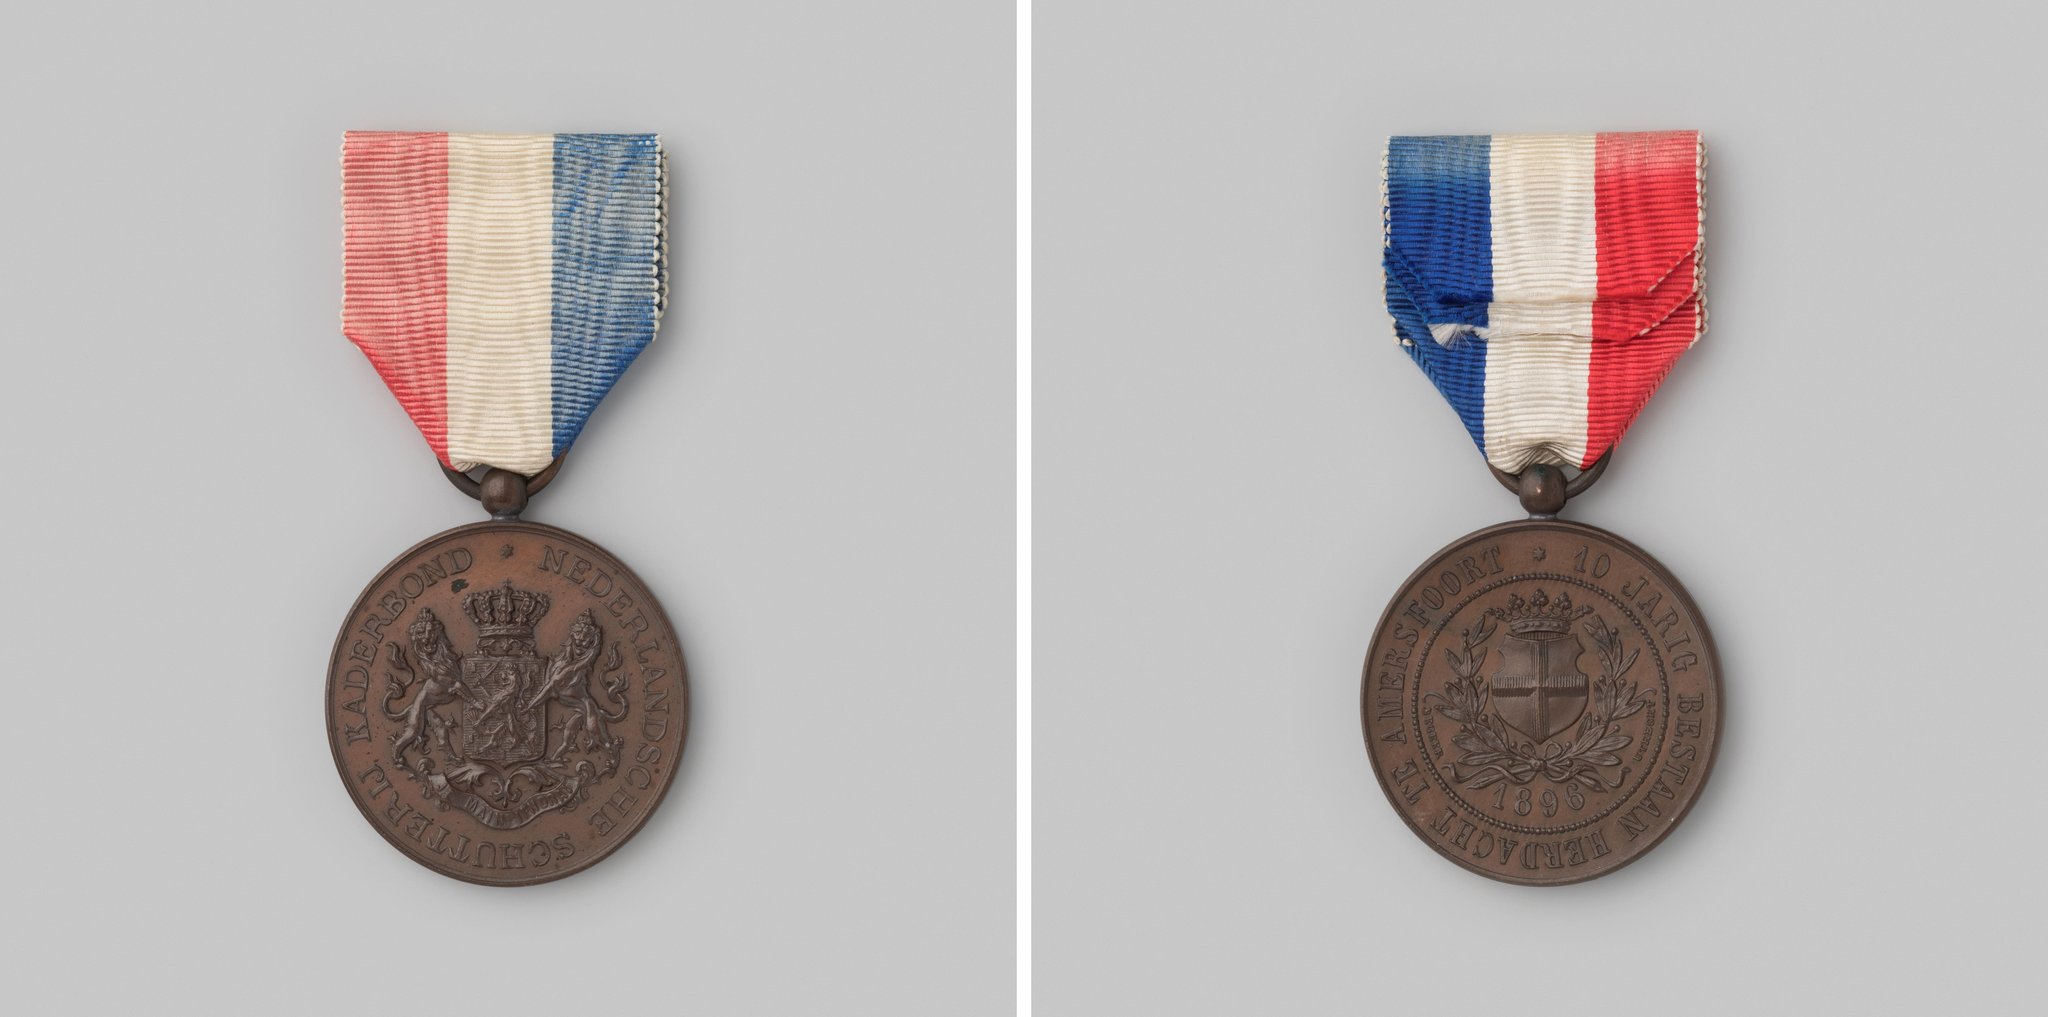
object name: history medal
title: Gedenkpenning van het tienjarig bestaan van de Nederlandschen Schutterij Kaderbond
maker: Anonymous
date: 1896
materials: bronze, textile